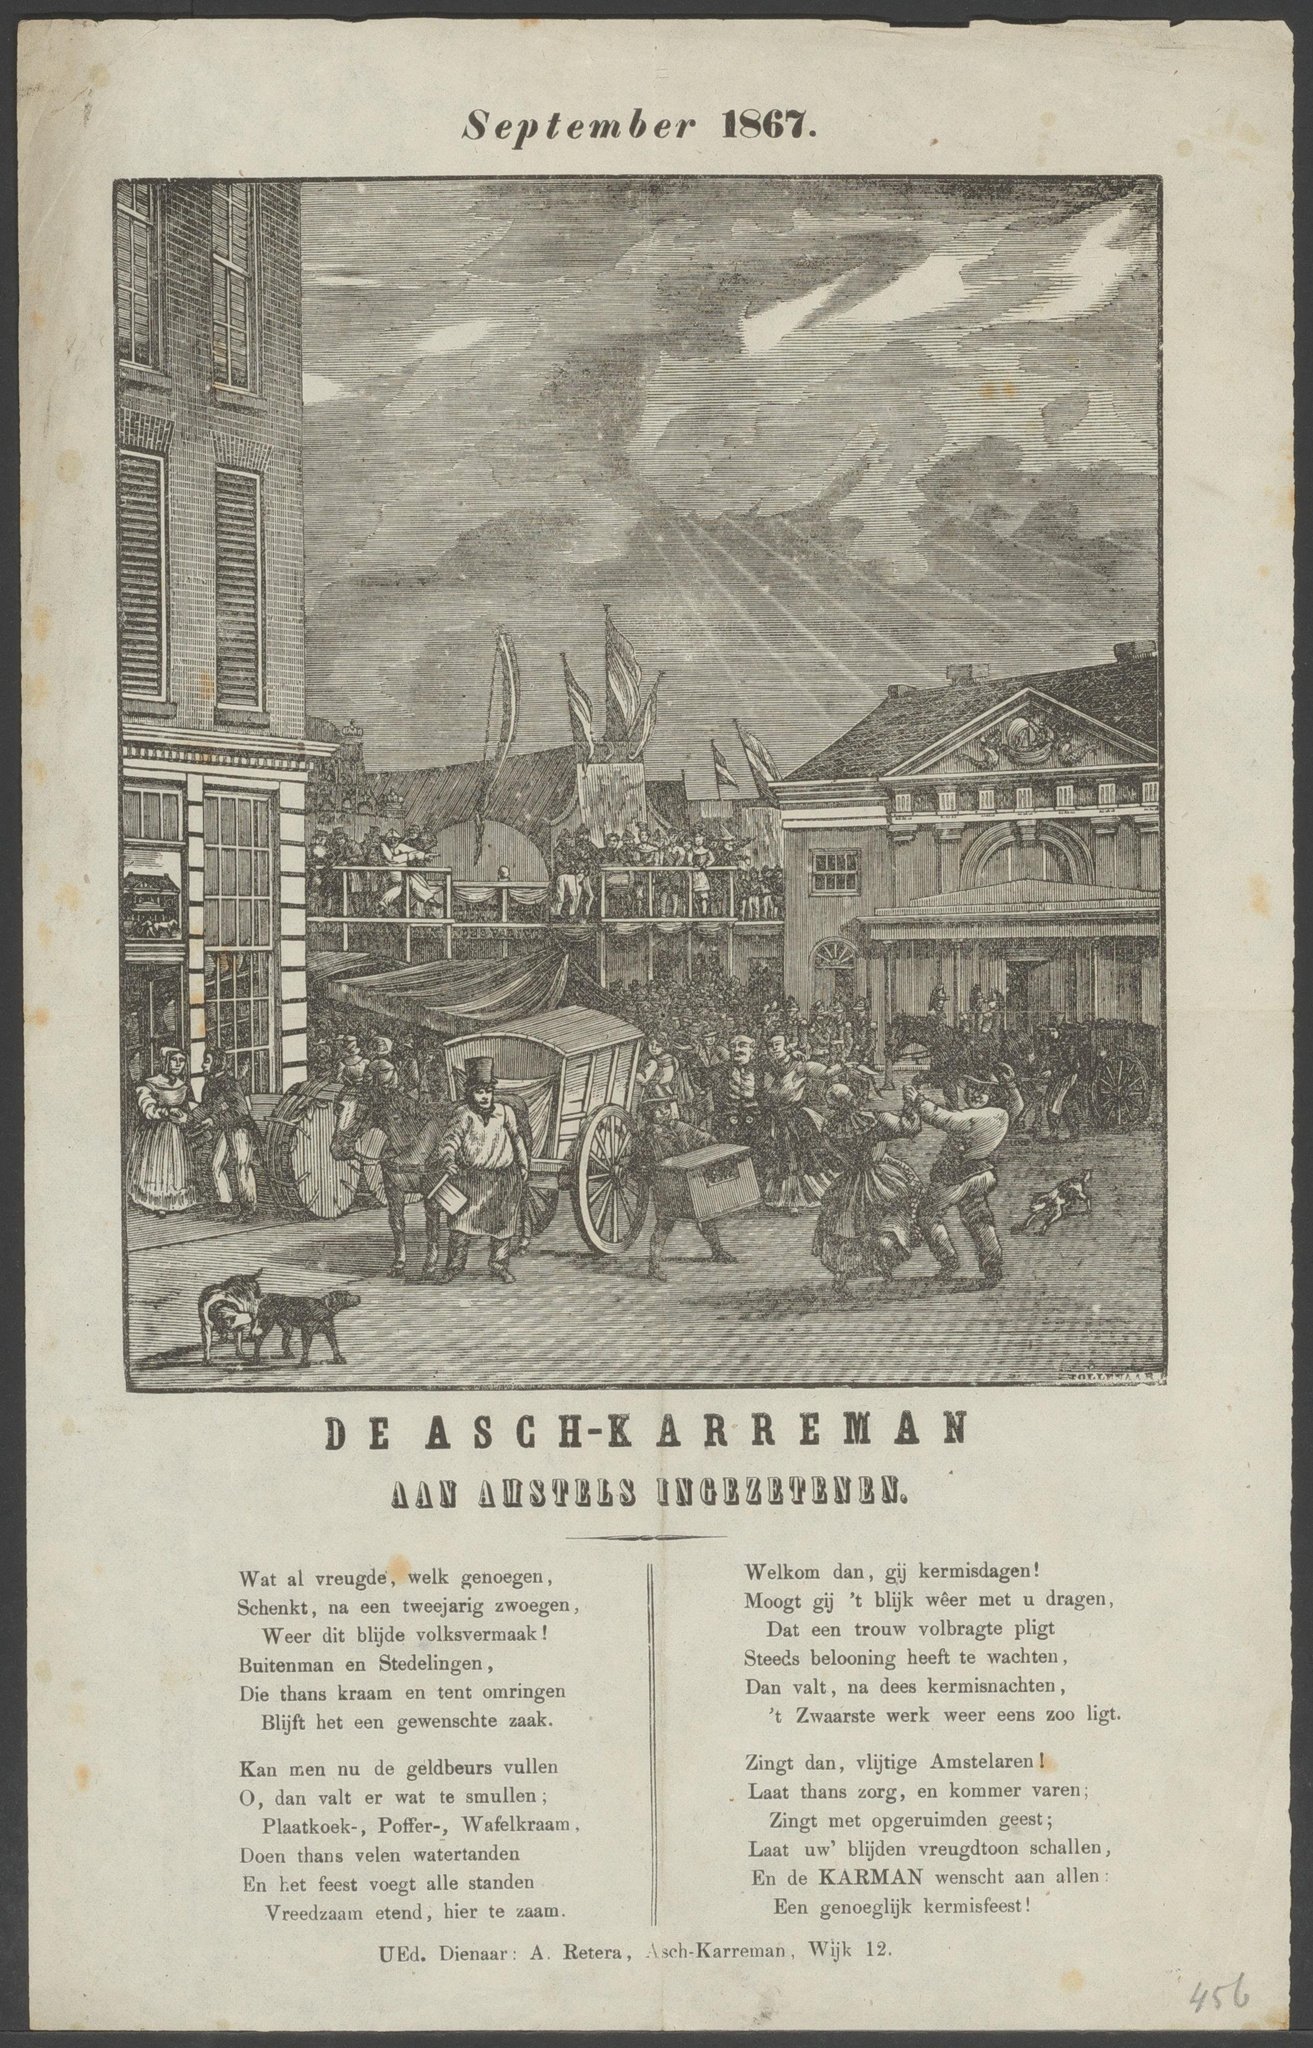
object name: fair print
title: Kermisprent van de Amsterdamse askarrenmannen voor het jaar 1867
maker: dirk wijbrand tollenaar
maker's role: print maker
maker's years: 1808-1858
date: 1867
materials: paper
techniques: letterpress printing, engraving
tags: pleasure fair and circus, garbage collection, amsterdam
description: Kermisprent namens de askarrenmannen (karrenman of vuilnisman) te Amsterdam, september 1867. Gezicht op de kermis op de Botermarkt met de Regulierswaag. Op de markt twee vuilniskarren. Onderaan een gedicht in twee kolommen. Namens A. Retara, de askarreman van wijk no. 12. Onderwerpsrubrieken binnen de Atlas Zeden en Gewoonten: Zeden en gewoonten in engeren zin, Volksleven, Volksbladen, Nieuwjaars- en Kerstwenschen, Amsterdam.